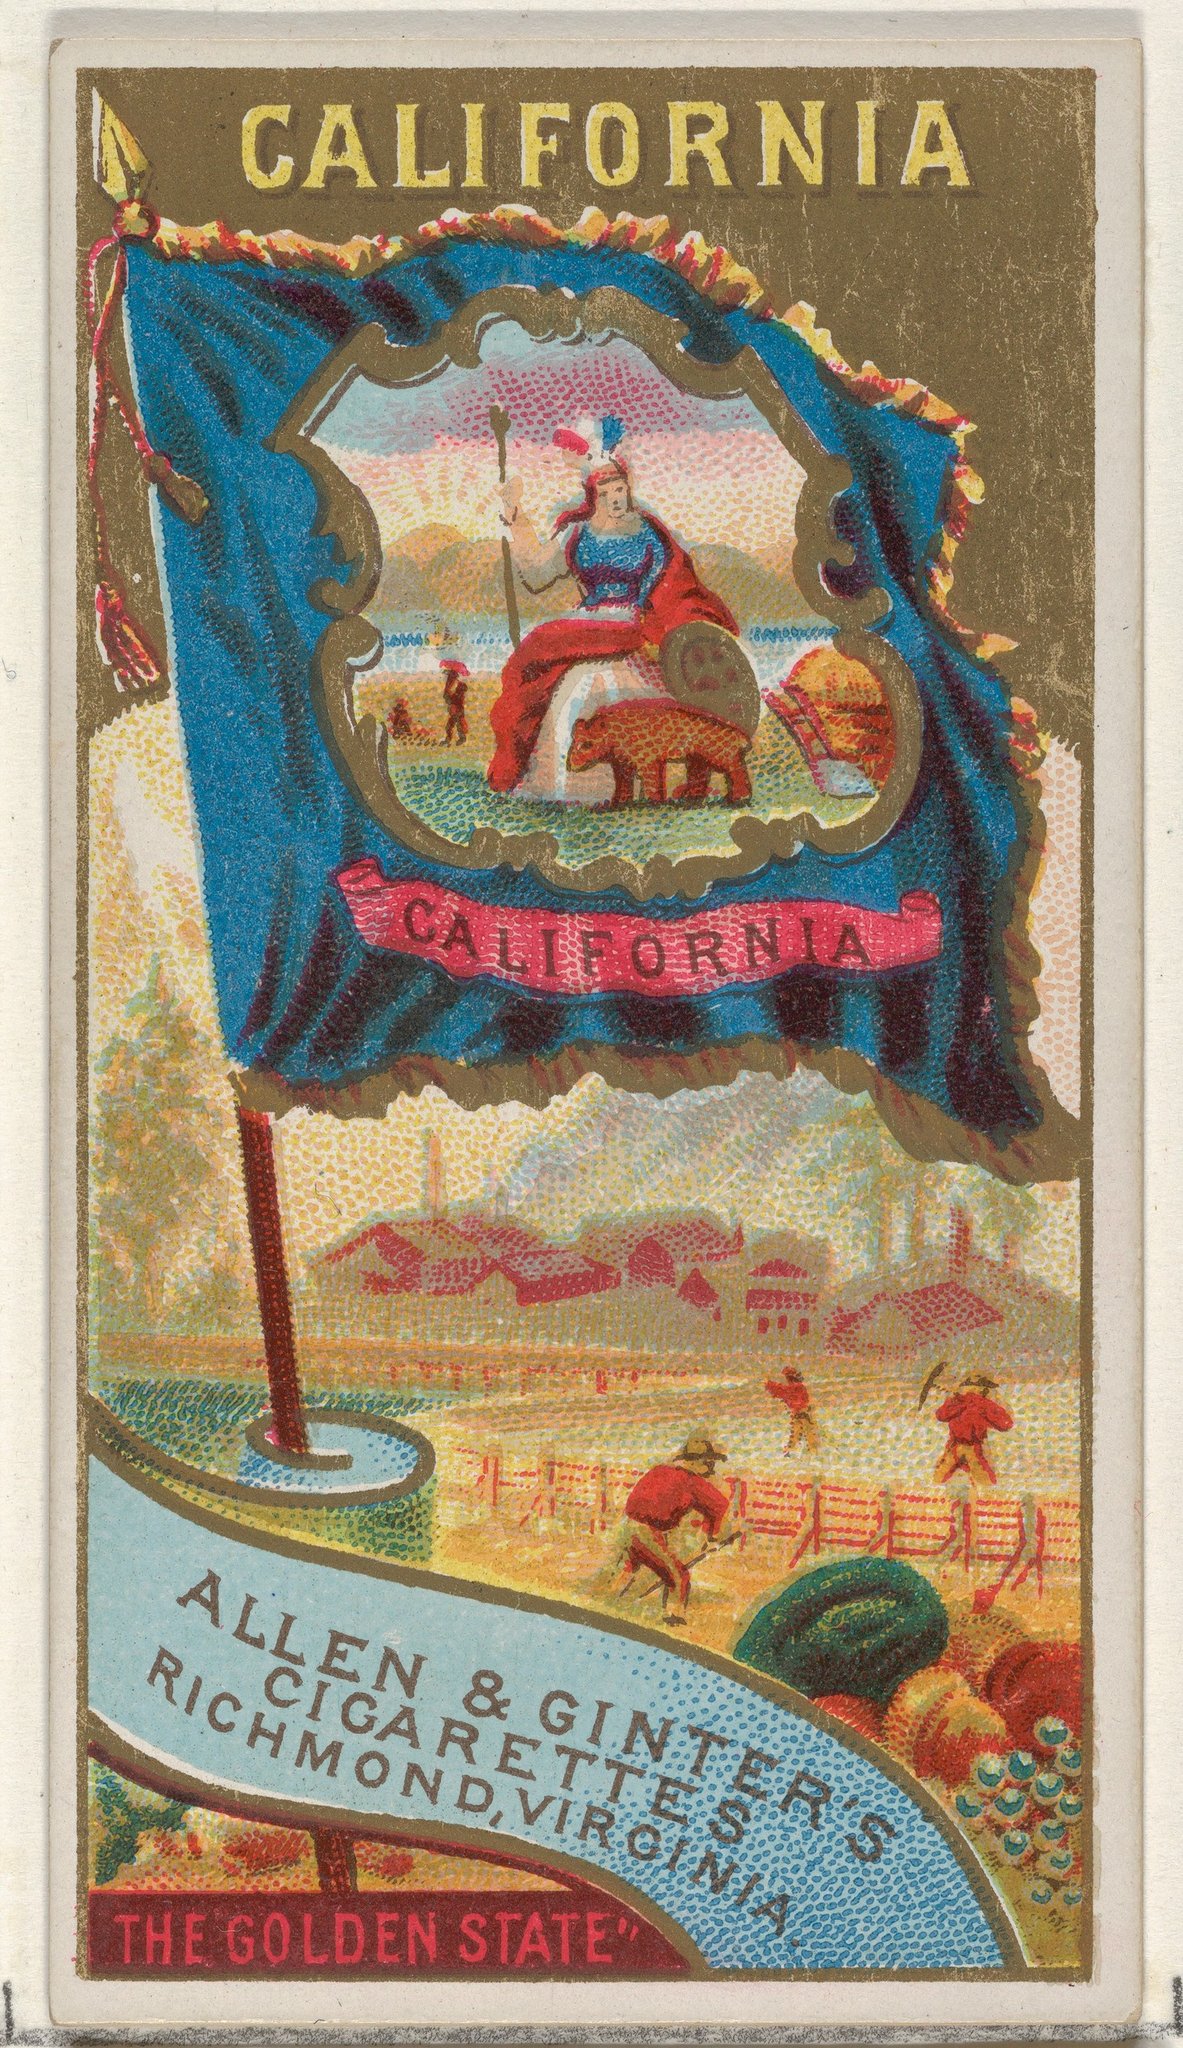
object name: print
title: California, from Flags of the States and Territories (N11) for Allen & Ginter Cigarettes Brands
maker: allen & ginter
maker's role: publisher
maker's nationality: american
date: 1888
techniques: color lithograph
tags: flags